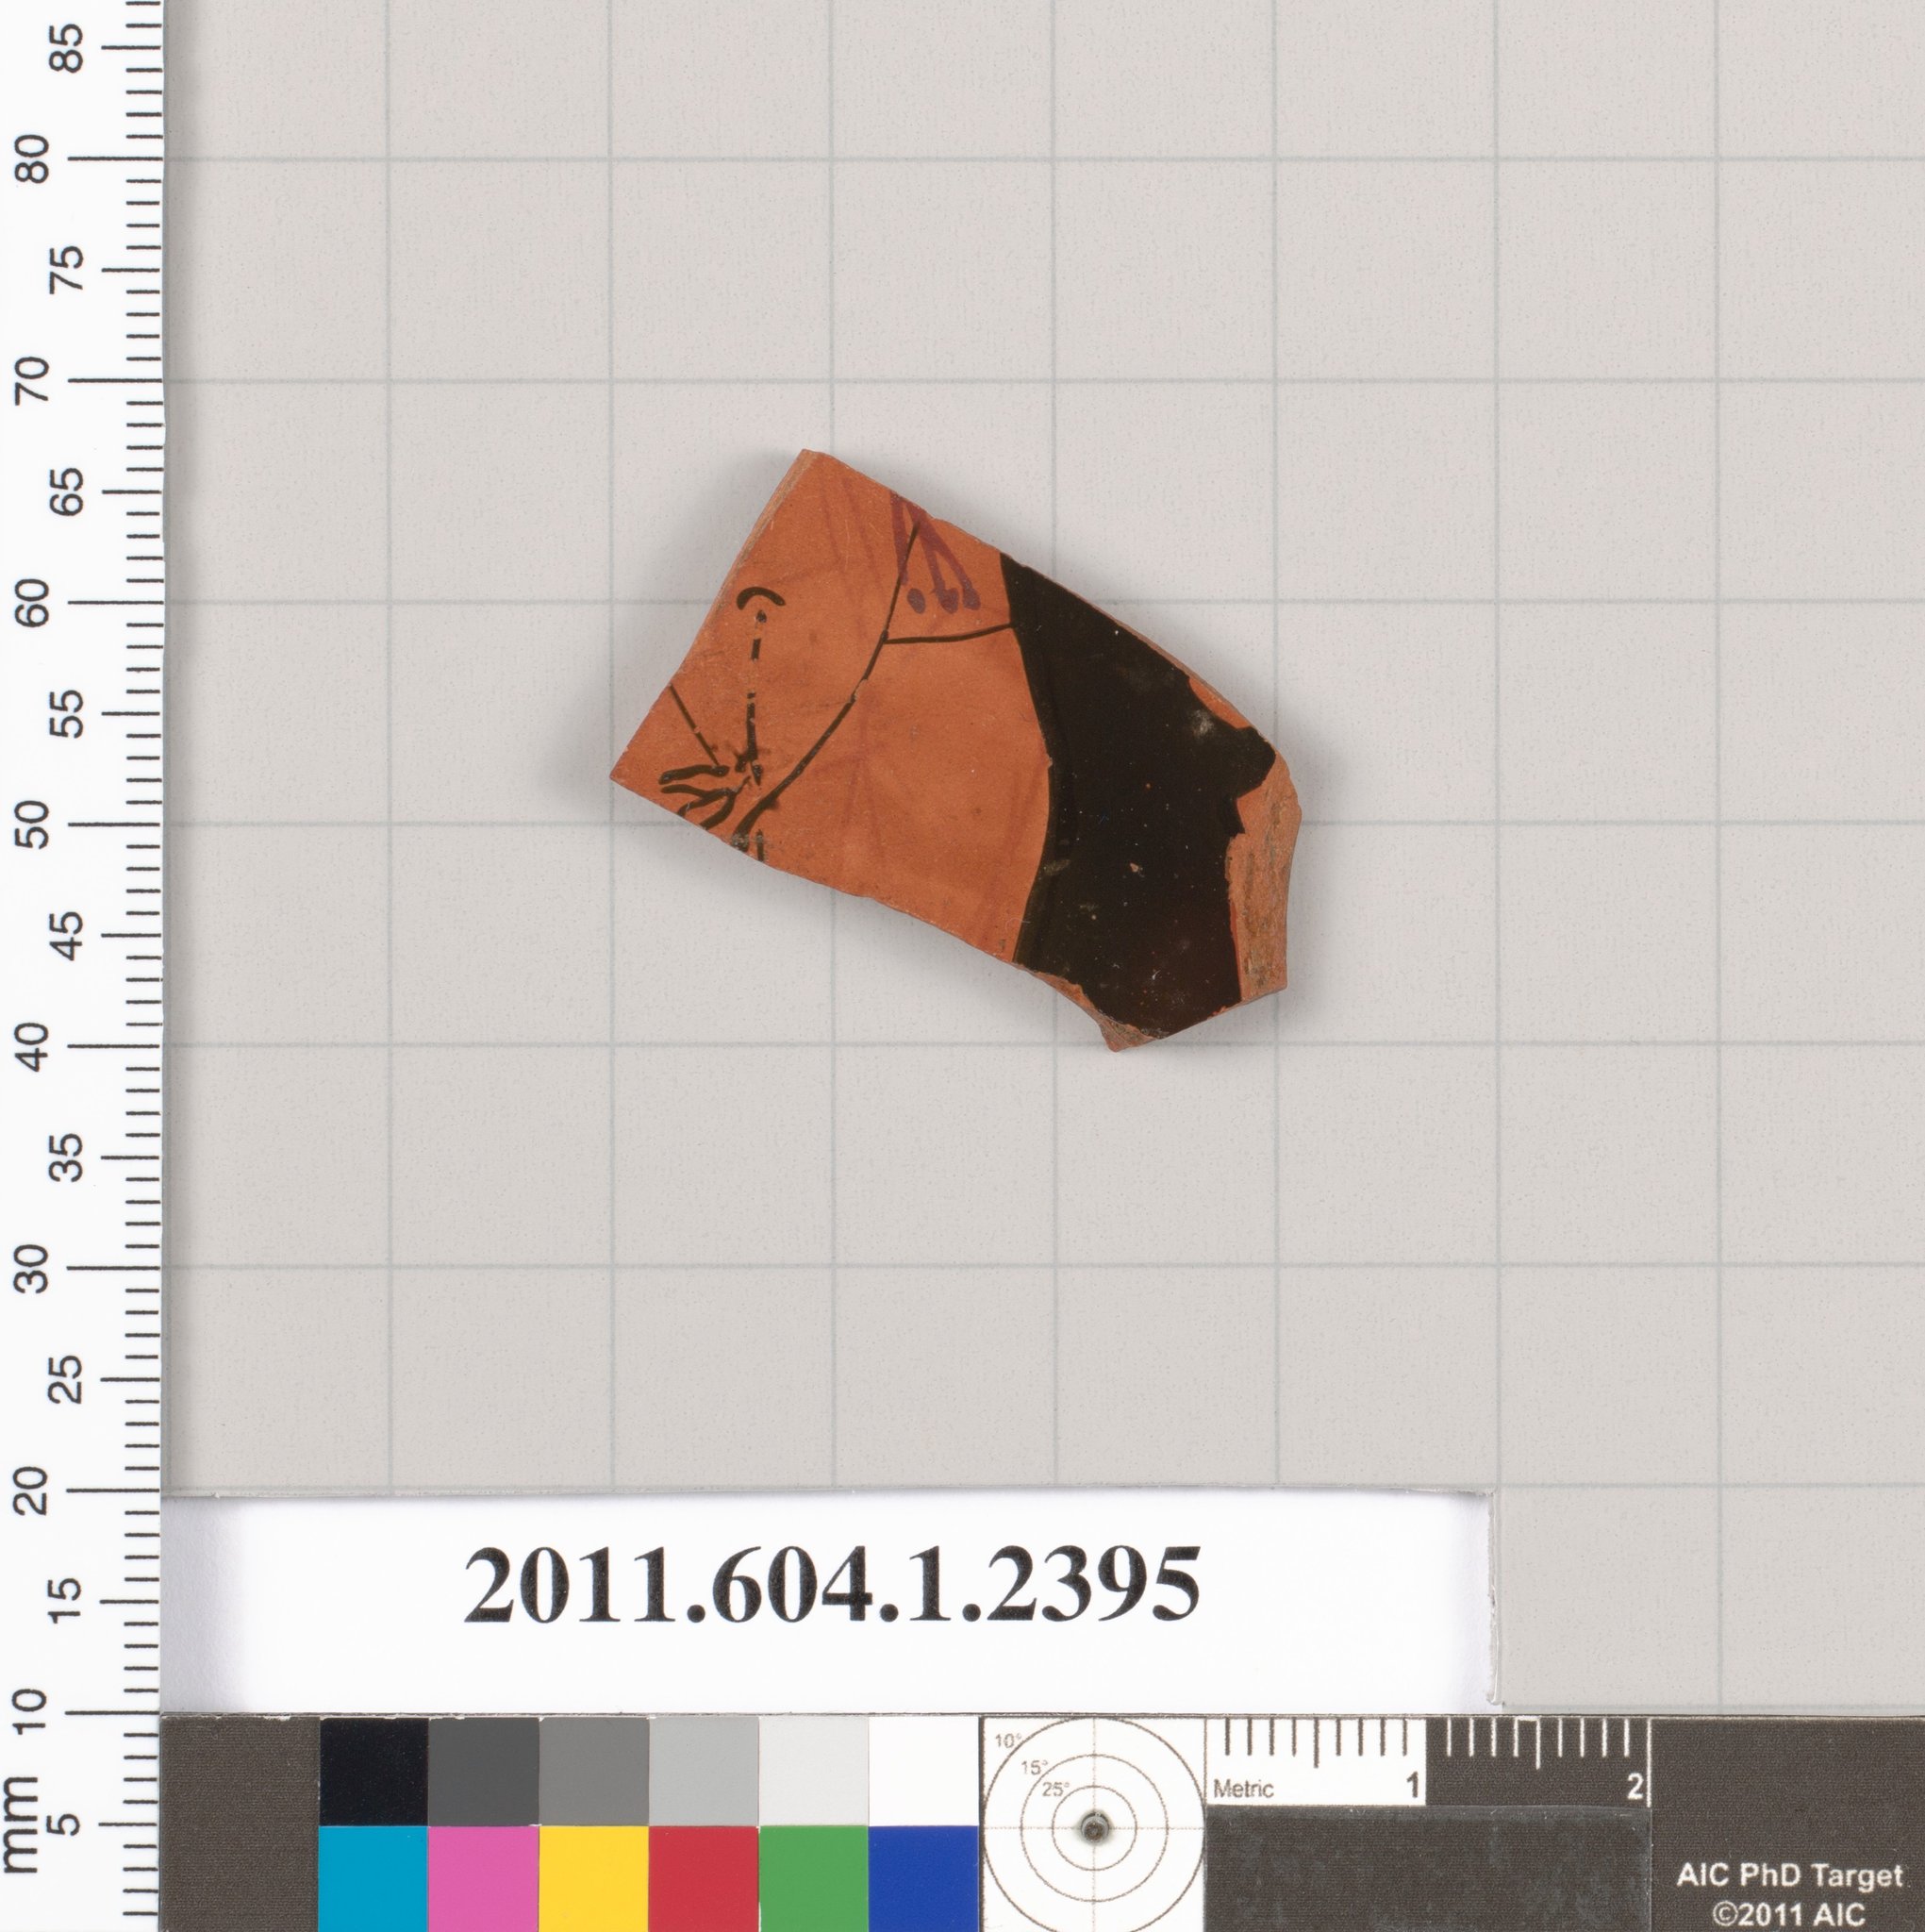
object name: kylix fragment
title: Terracotta fragment of a kylix (drinking cup)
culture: greek, attic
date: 490-480 BCE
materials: terracotta